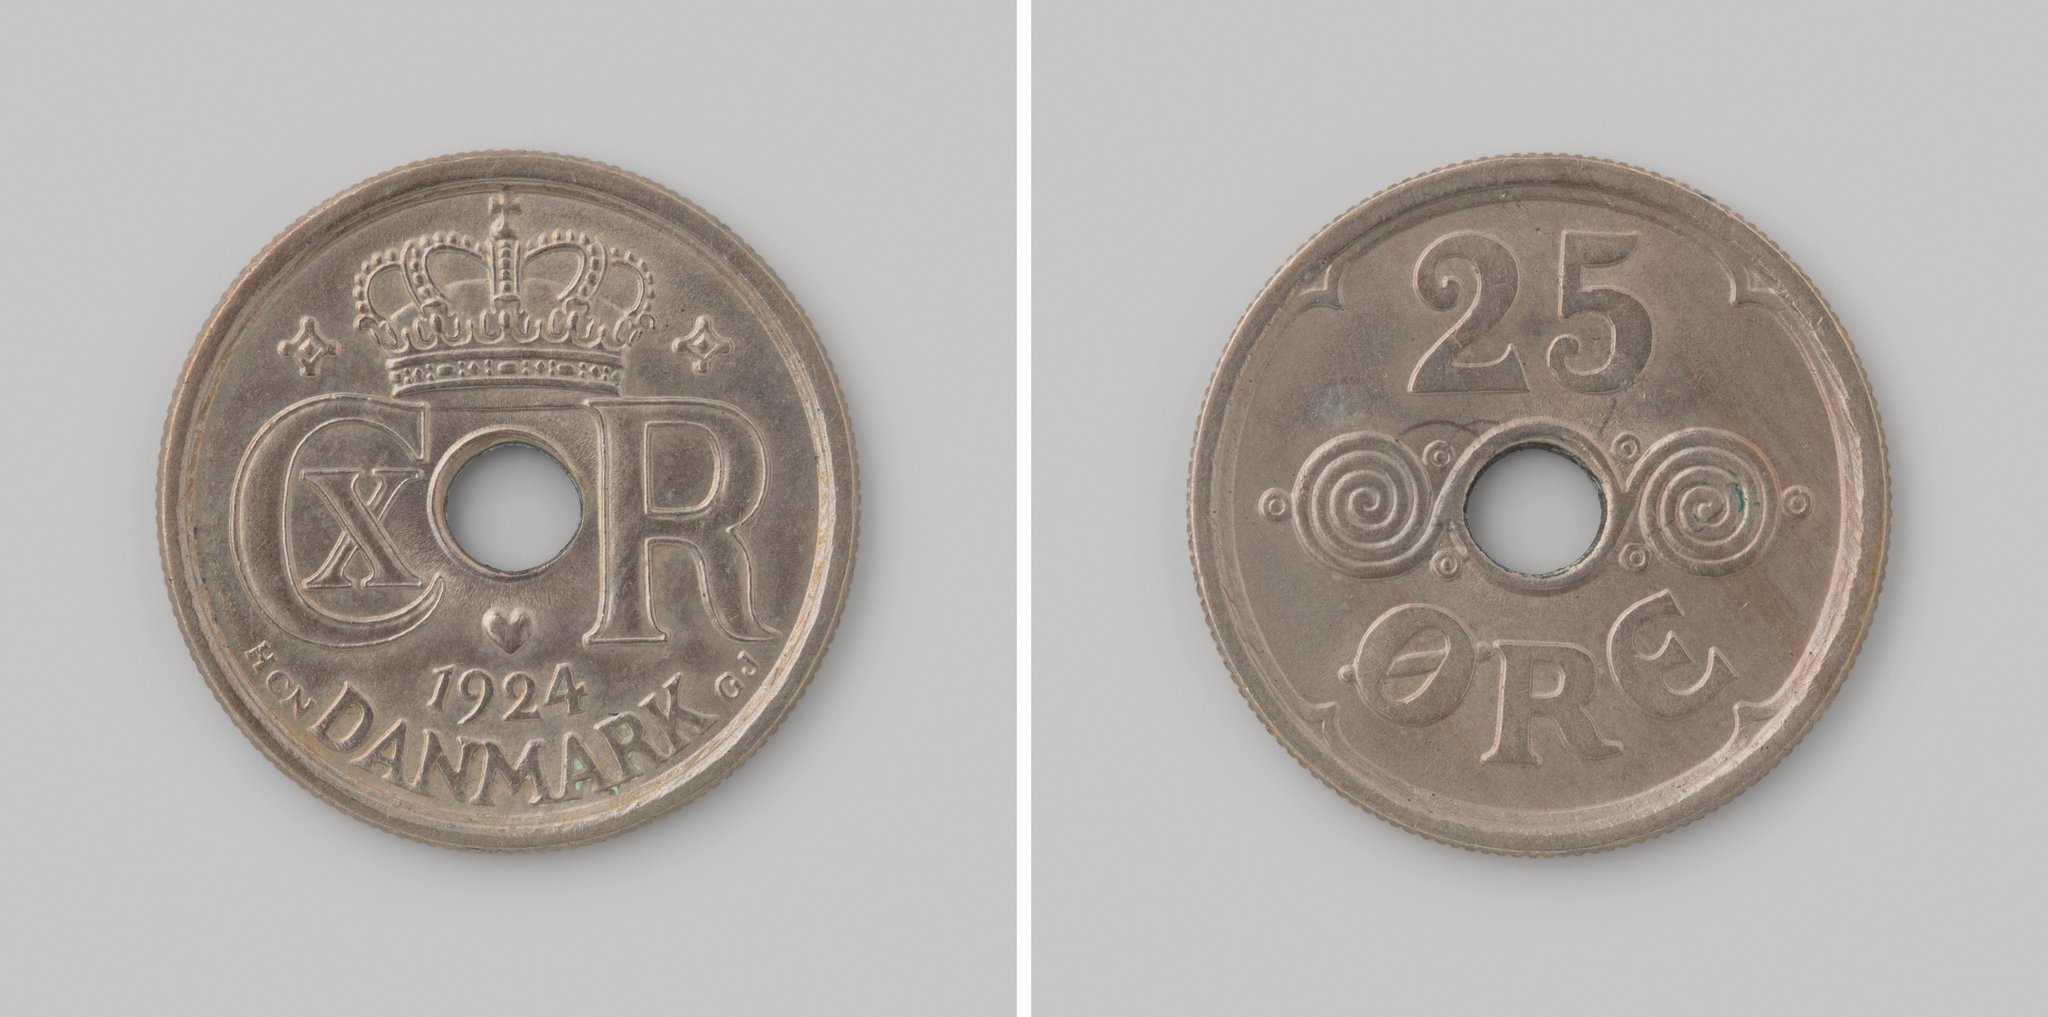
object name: vijfentwintig øre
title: Denemarken, Christiaan X, 25 øre, 1924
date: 1924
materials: nickel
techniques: striking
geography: copenhagen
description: Koper-nikkelen munt. Voorzijde: gekroond monogram van de koning met letter R. Daaronder jaartal. Keerzijde: waarde-aanduiding bovenaan in twee regels, waartussen versiering, in veld. Centrale doorboring. Gladde rand.